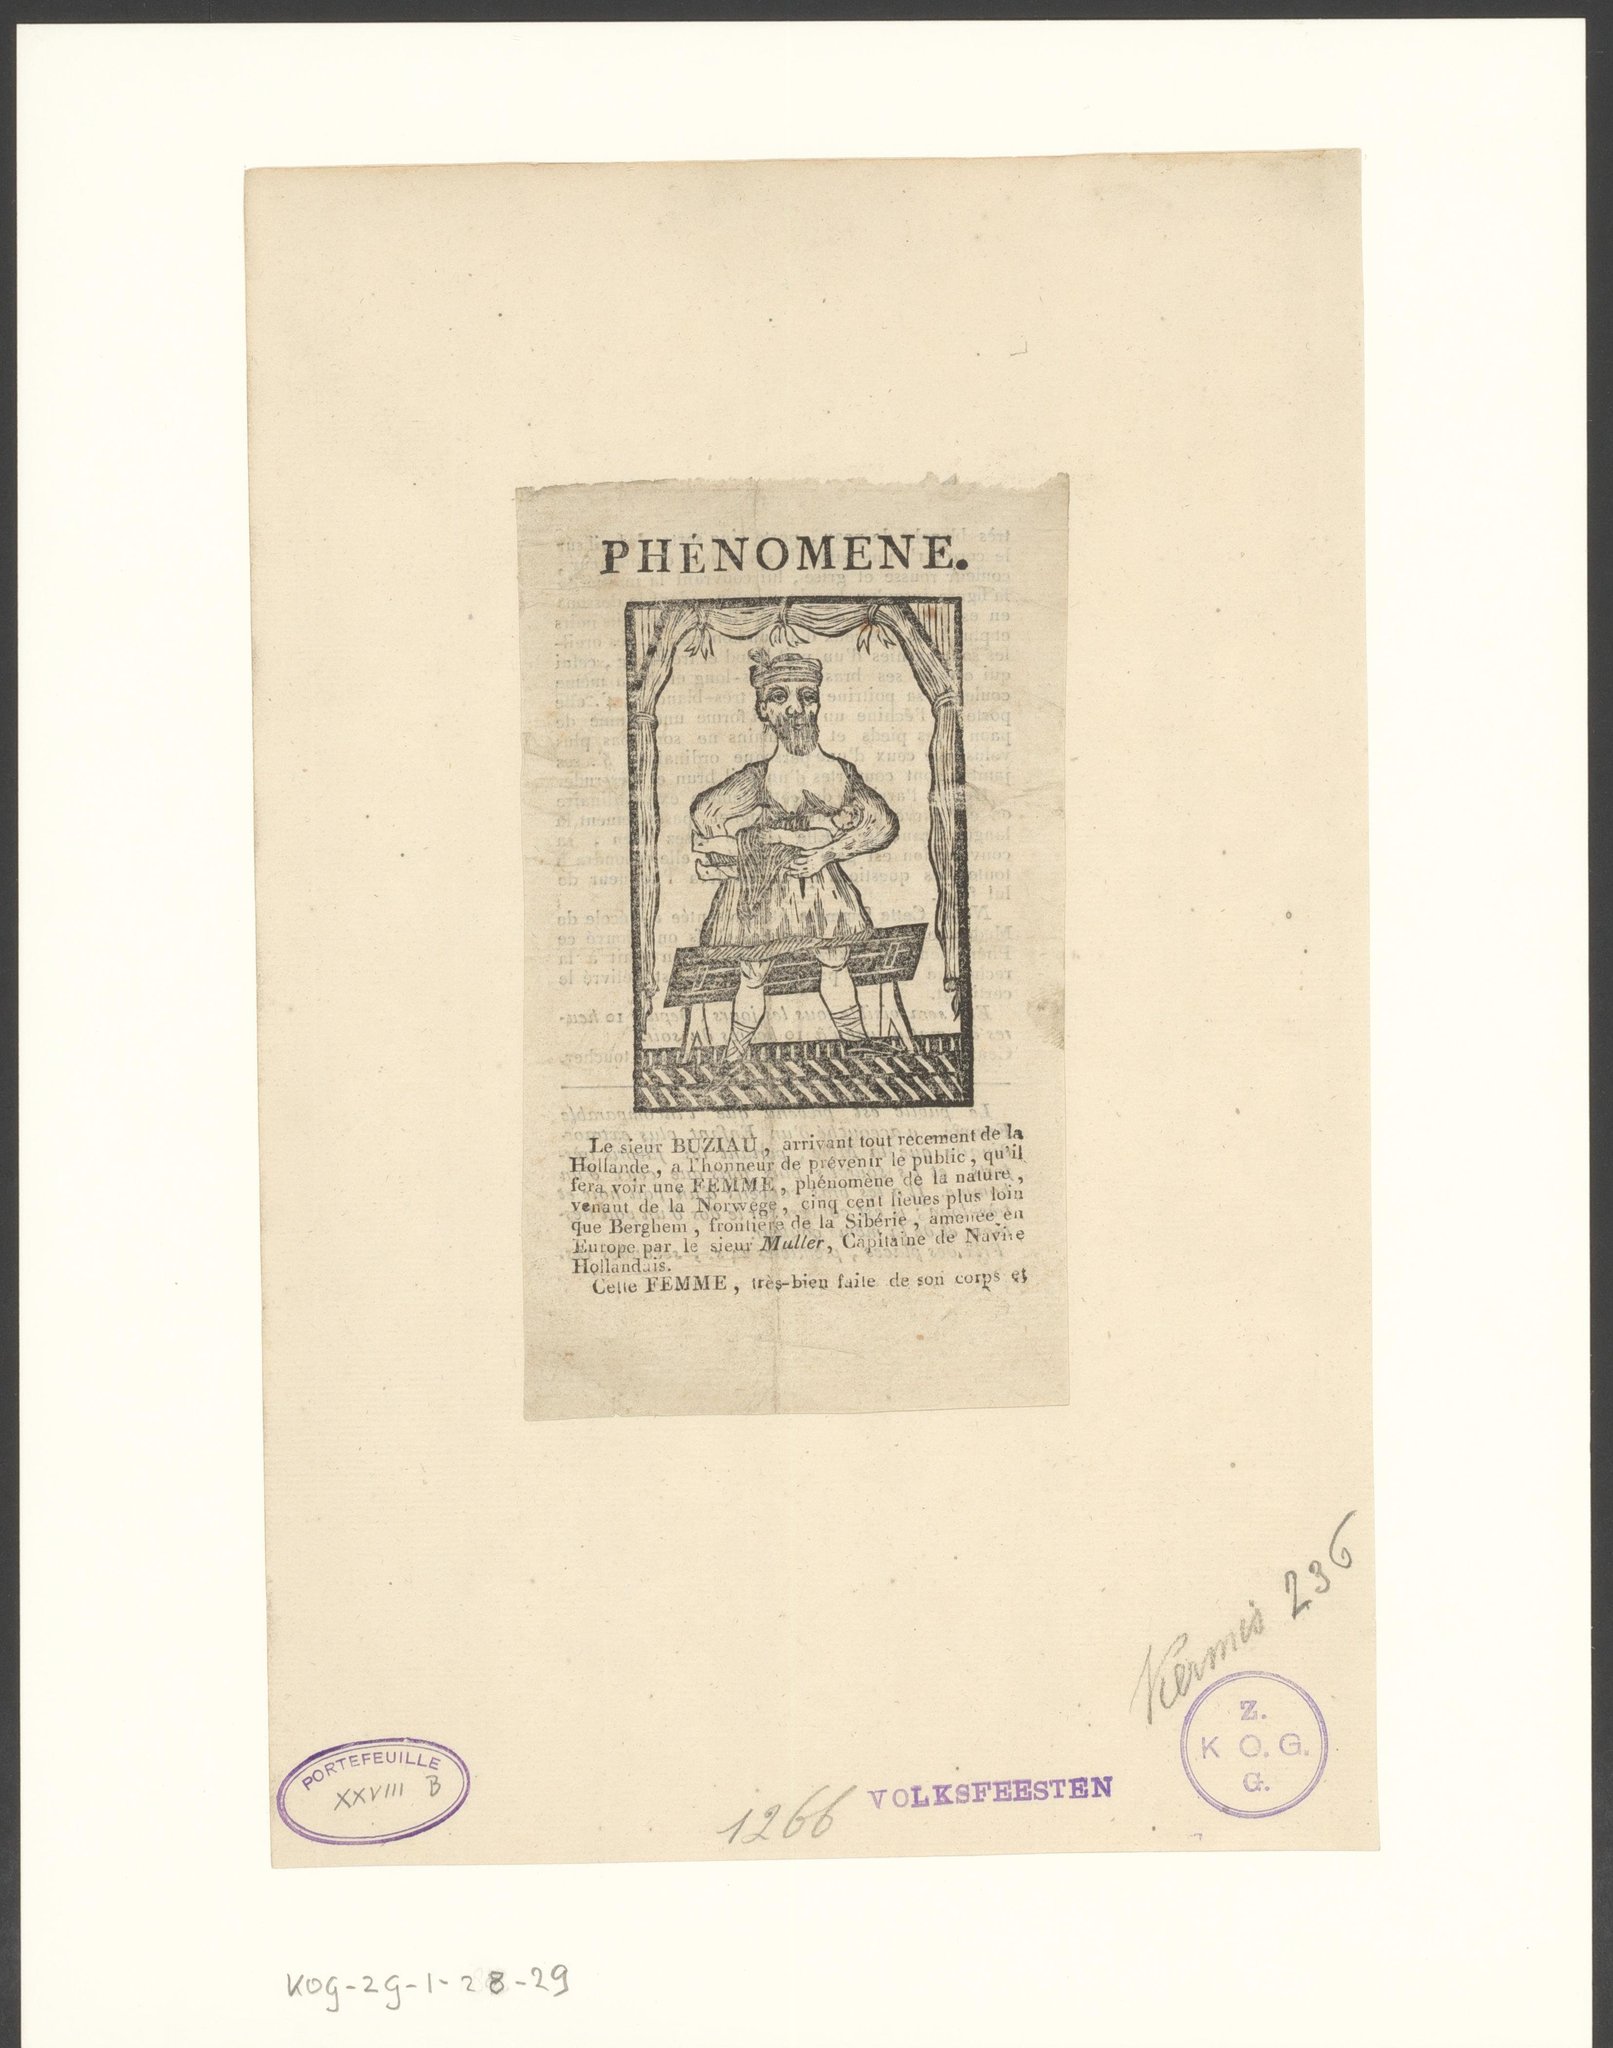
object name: print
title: Vrouw met een baard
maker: Anonymous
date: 1800-1899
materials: paper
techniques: letterpress printing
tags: human monstrosities ~ freak show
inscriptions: collector's mark: Lugt 1641, stamp, stamp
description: Onderwerpsrubrieken binnen de Atlas Zeden en Gewoonten: Zeden en Gewoonten in Engeren Zin. Volksleven. Volksfeesten. Kermistypen, wondermenschen en dergelijken.